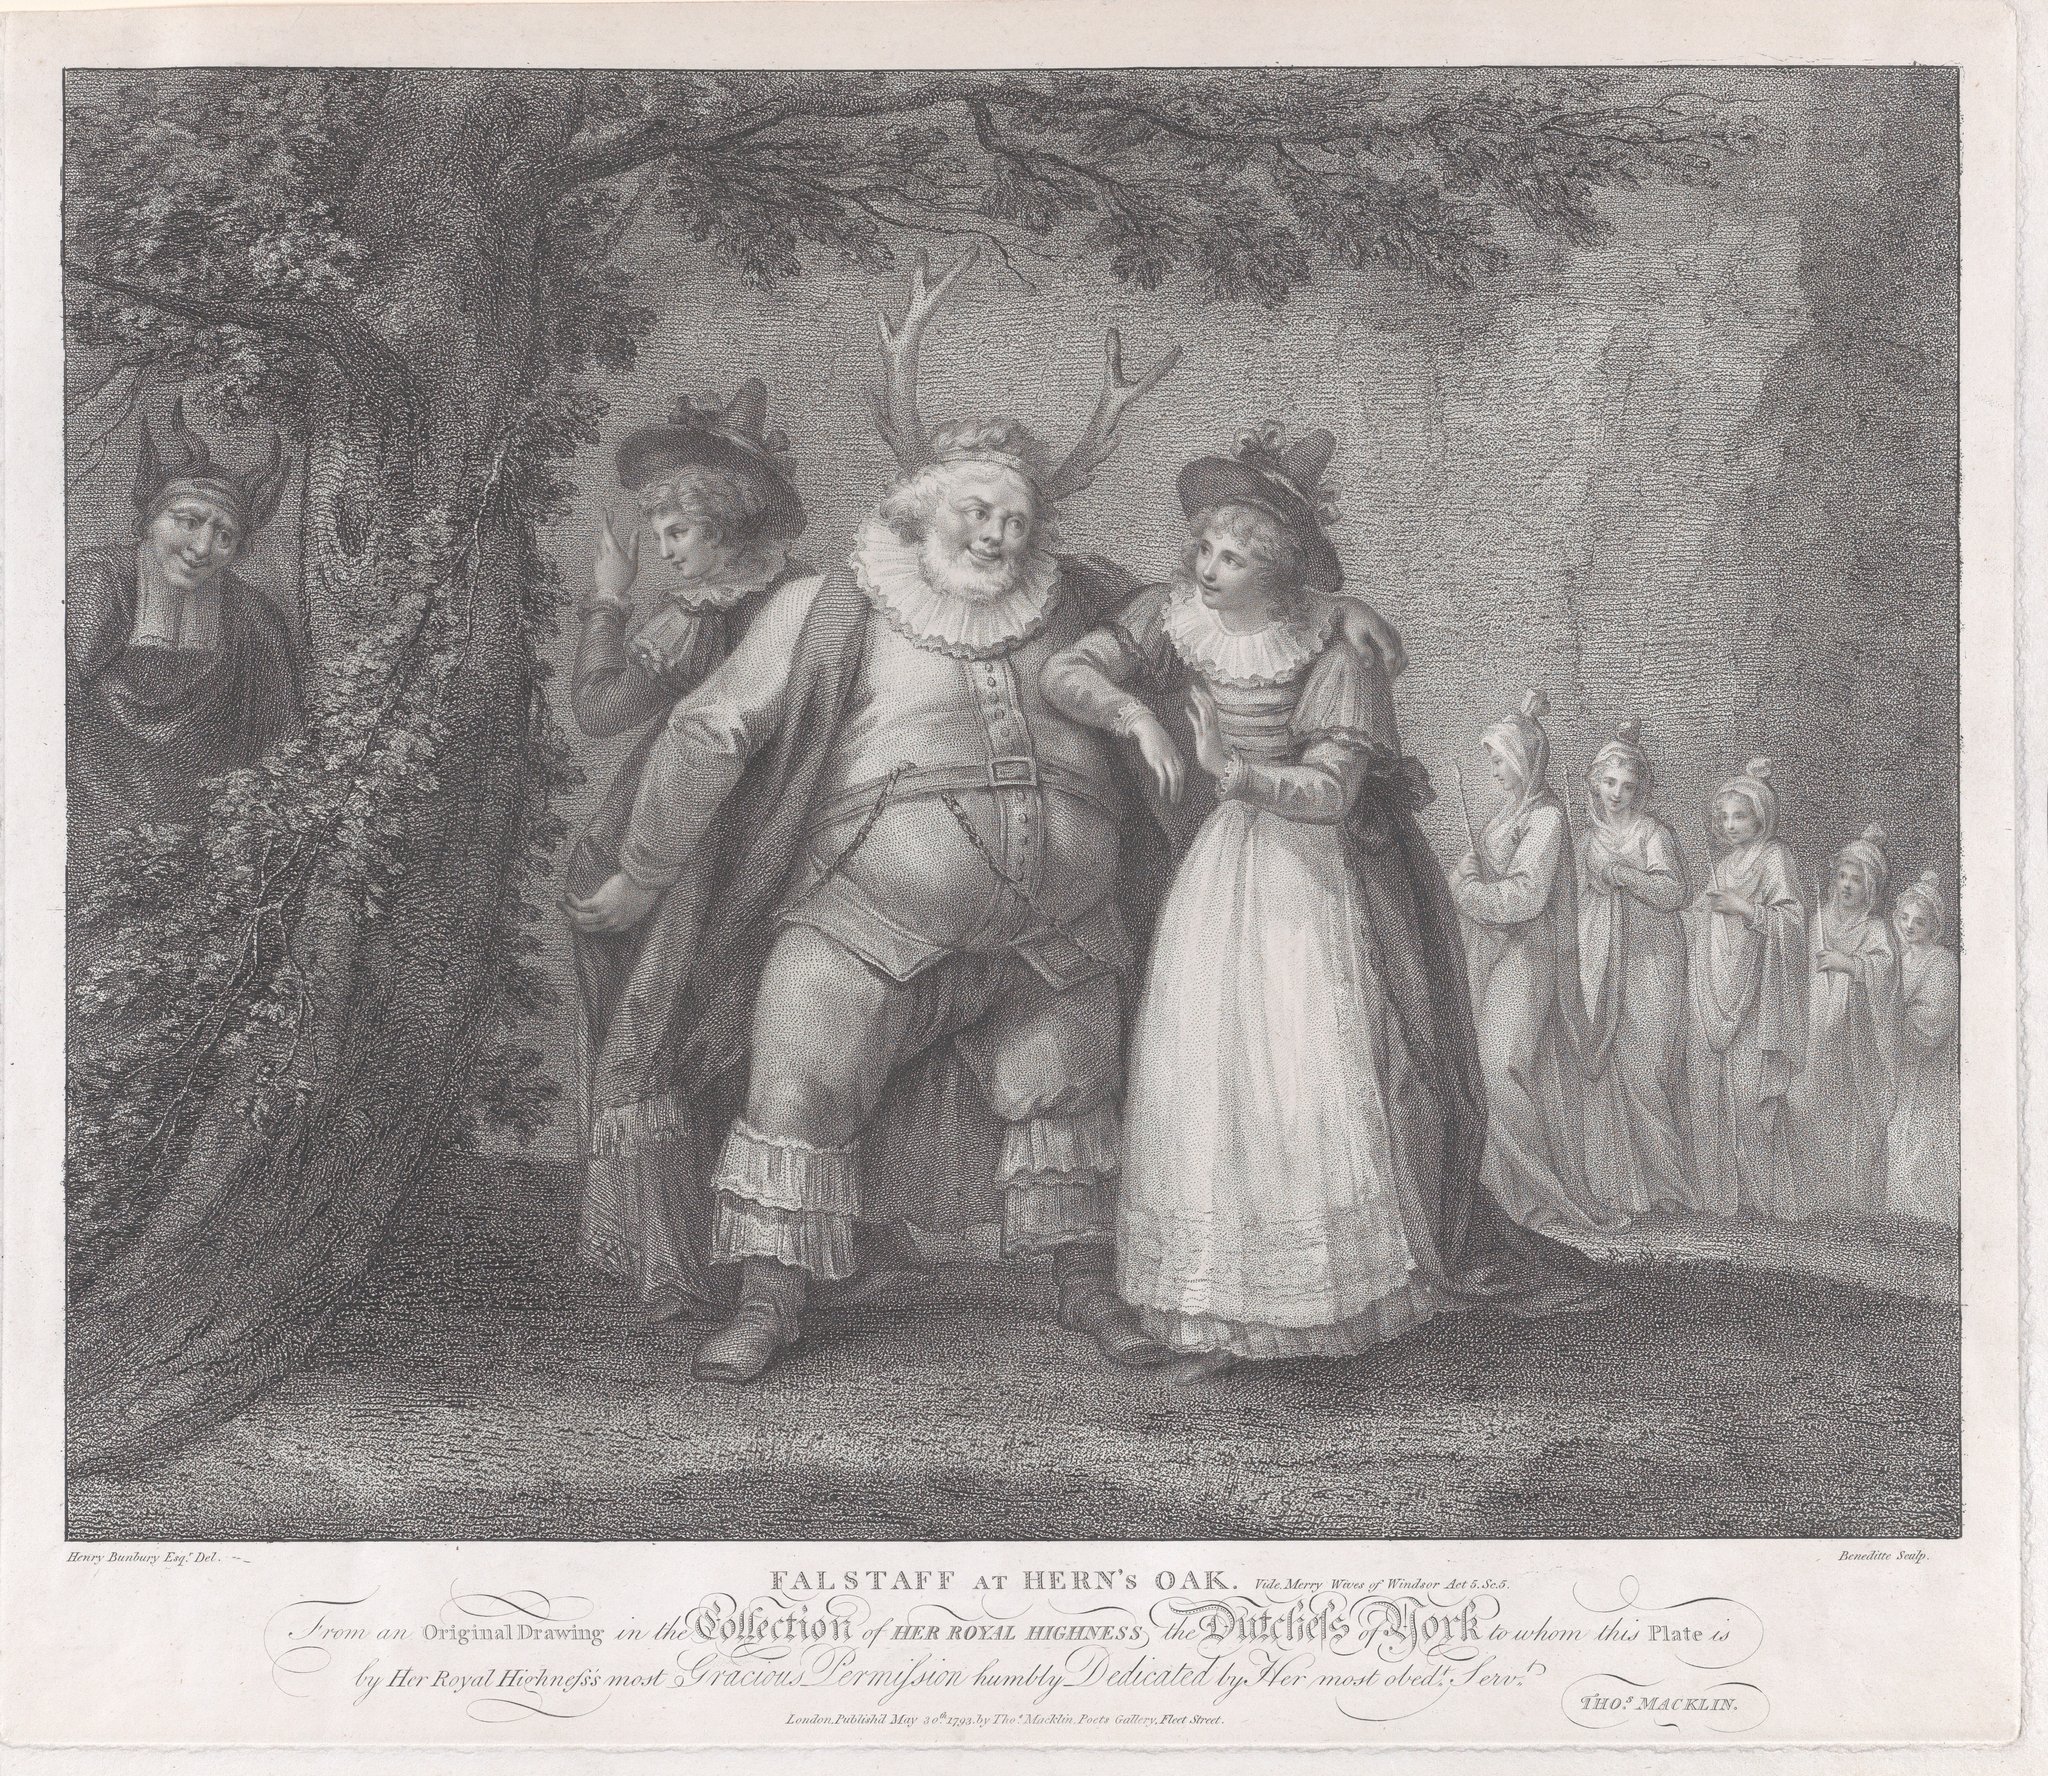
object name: print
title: Falstaff at Herne's Oak (Shakespeare, Merry Wives of Windsor, Act 5, Scene 5)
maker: michele beneditti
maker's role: engraver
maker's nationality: british, italian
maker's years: 1745-1810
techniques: etching, engraving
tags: shakespeare,men,women